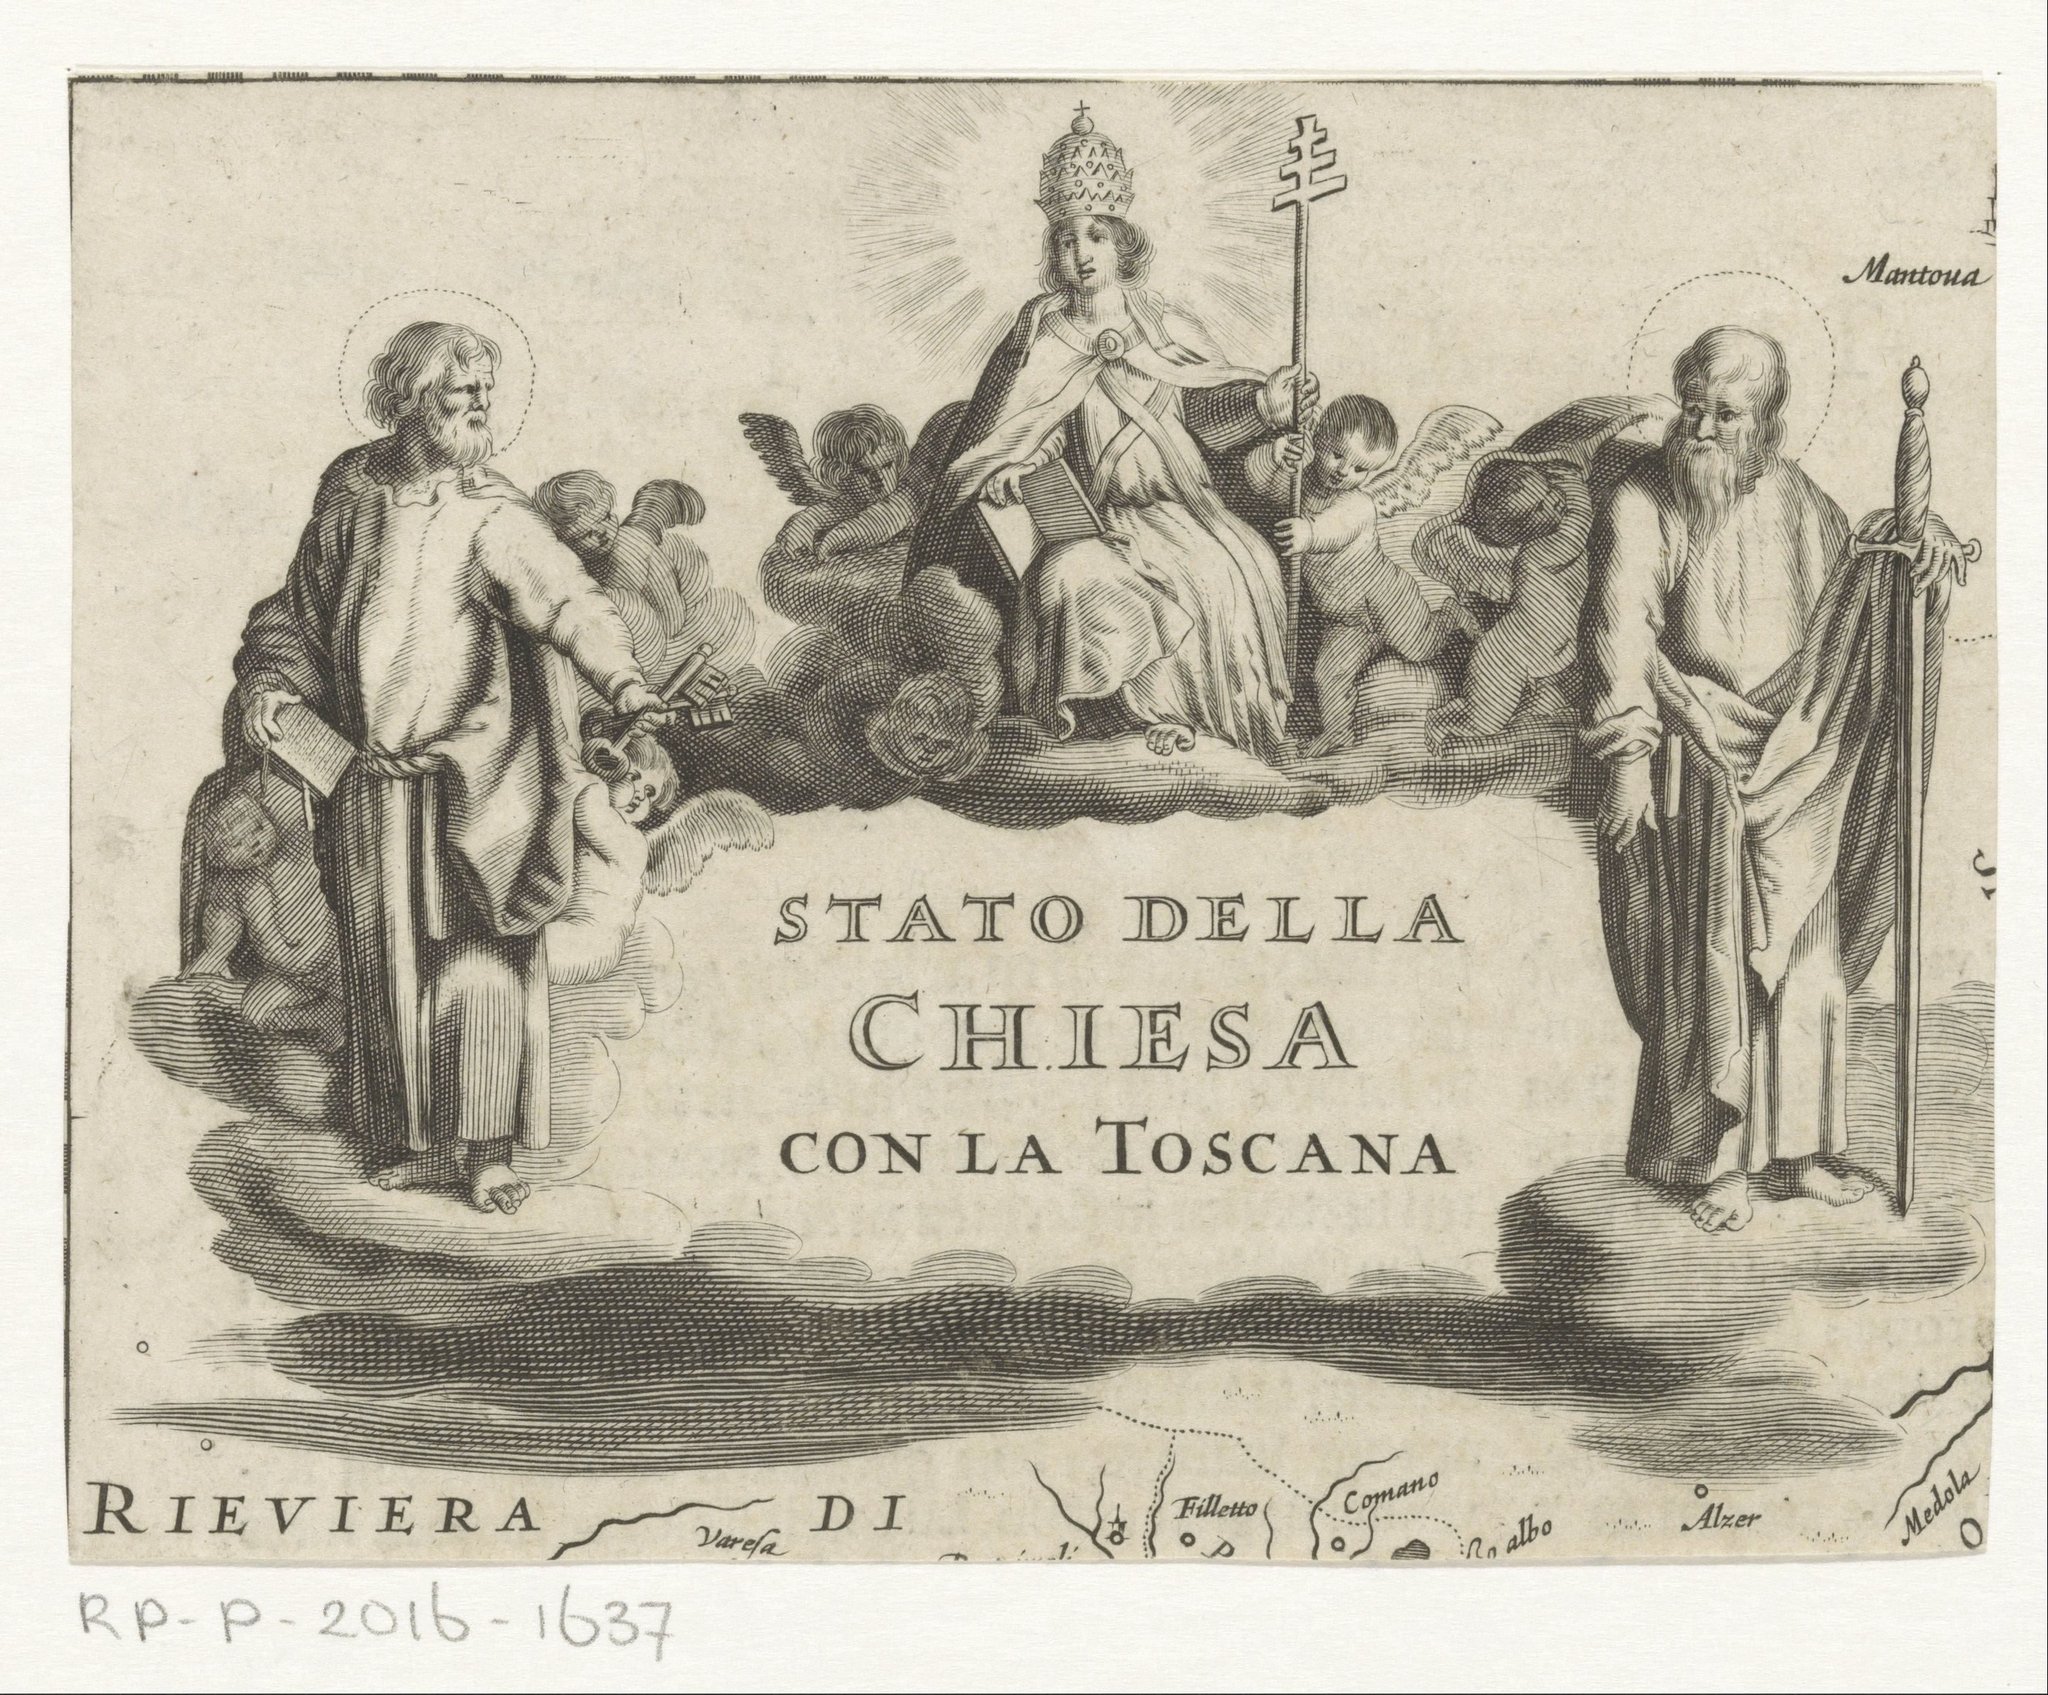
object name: print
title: Stato della Chiesa con la Toscana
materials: paper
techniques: engraving, letterpress printing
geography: amsterdam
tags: fides (faith) as roman personification, the apostle peter, first bishop of rome; possible attributes: book, cock, (upturned) cross, (triple) crozier, fish, key, scroll, ship, tiara, the apostle paul of tarsus; possible attributes: book, scroll, sword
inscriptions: collector's mark: Lugt 2228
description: Petrus met sleutels en Paulus met zwaard flankeren de titel. Daarboven zit de personificatie van Geloof met pauselijke tiara en kruisstaf op wolken omringd door putti. Detail van een kaart van de kerkelijke staat en Toscane.